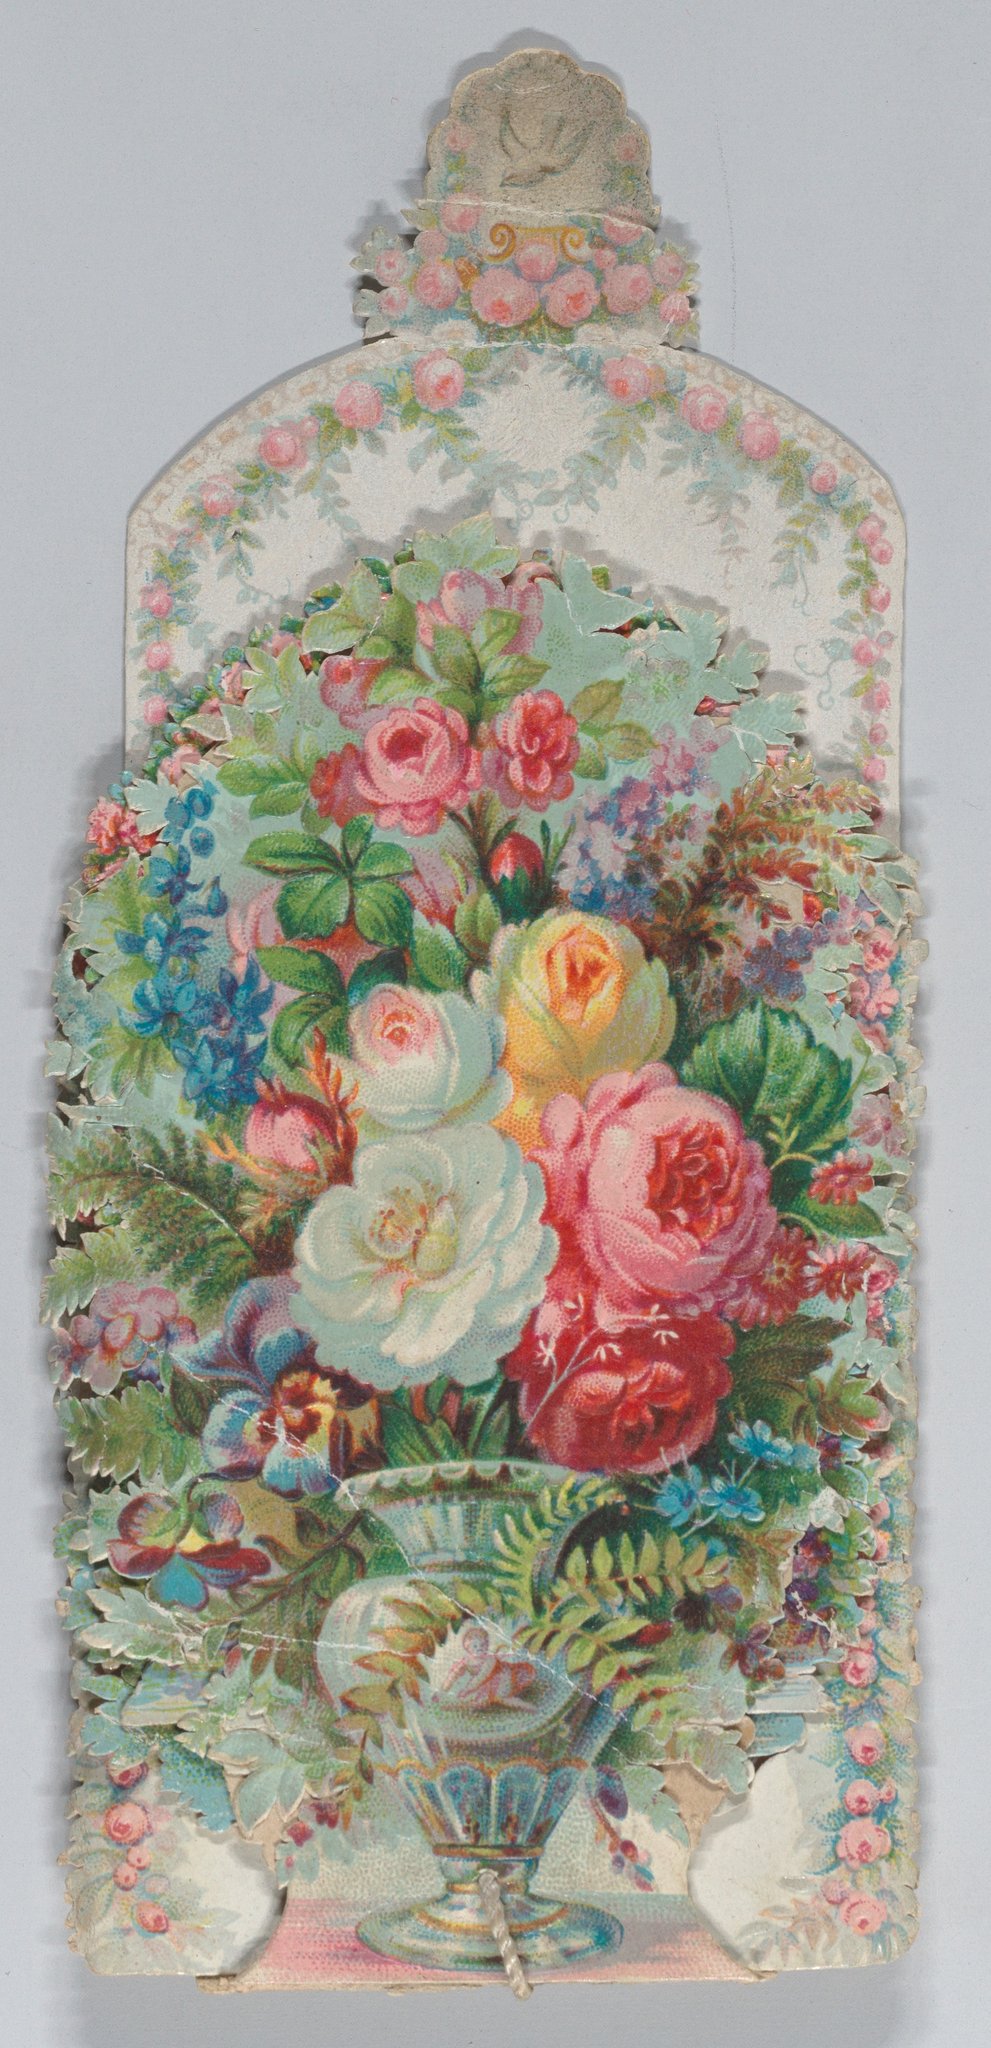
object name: valentine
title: Valentine - Mechanical -- a decorated armoire (chest)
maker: anonymous, british, 19th century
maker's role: artist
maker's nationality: british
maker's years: 1800-1900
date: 1875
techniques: chromolithography, cutting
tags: flowers